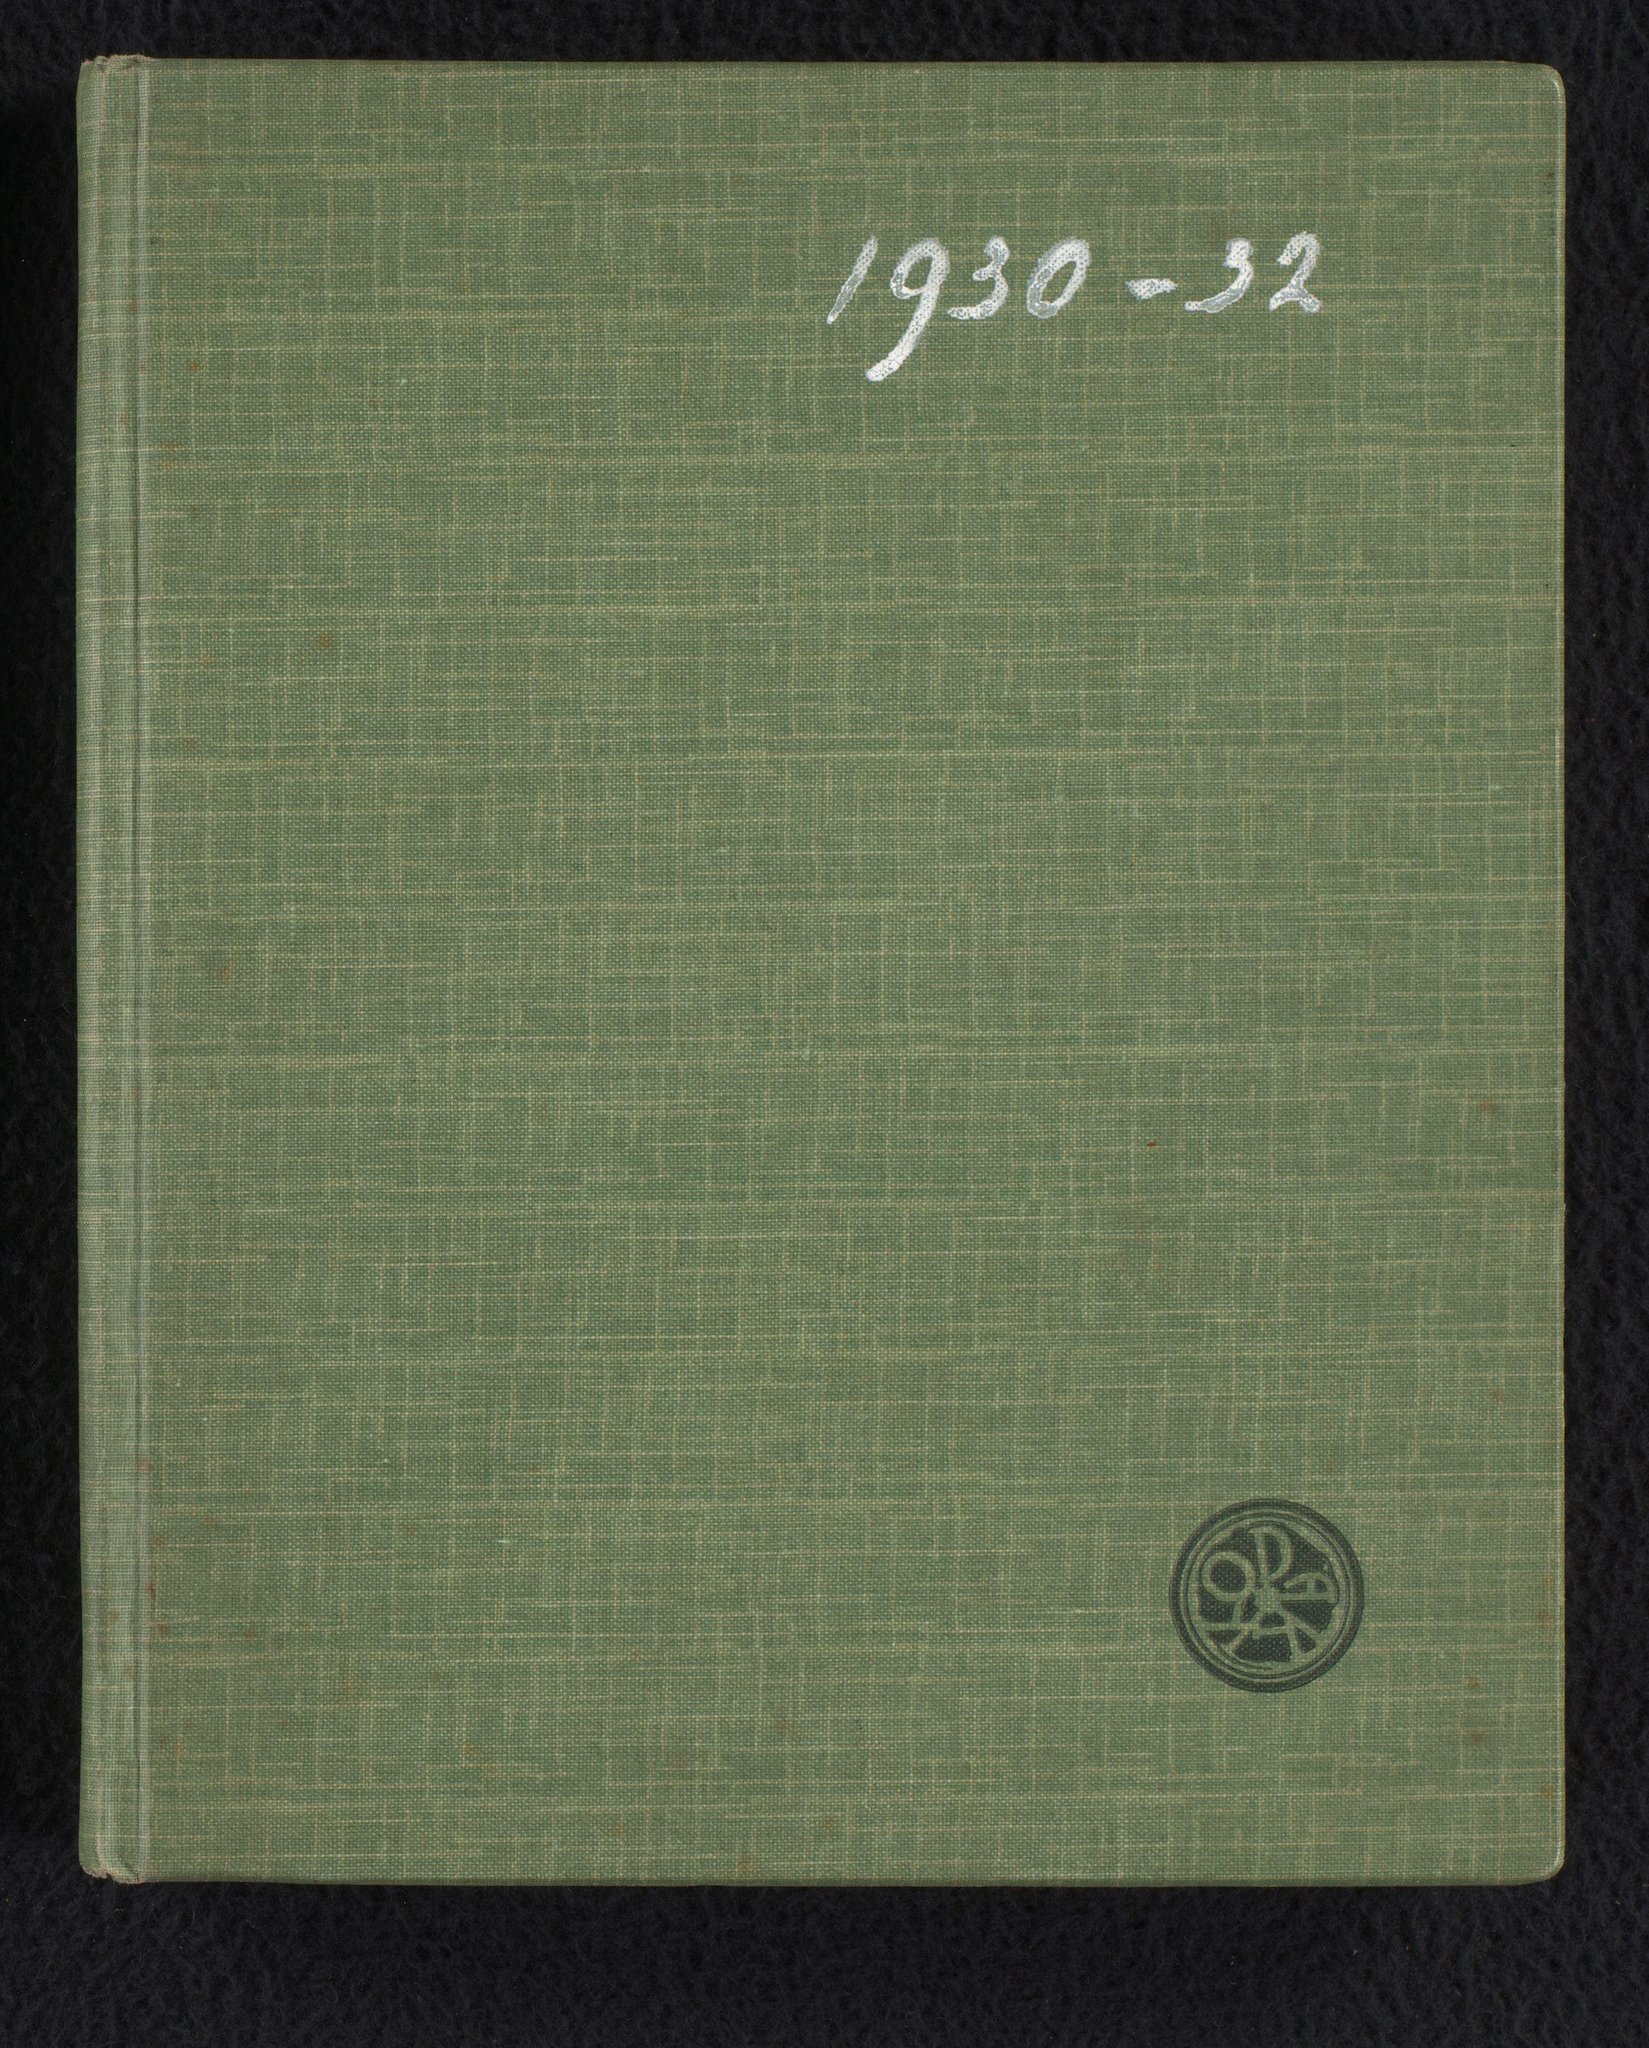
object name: photograph album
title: Fotoalbum van familie Van den Berg, 1930-1932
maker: frank willem van den berg (1912-1998)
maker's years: 1912-1998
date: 1930-1932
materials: paper, cardboard, ink, linen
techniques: gelatin silver print, pen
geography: netherlands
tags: batavia, amsterdam, hendrik herman van den berg, caroline louise van den berg-van den berg, frank willem van den berg (1912-1998), historical persons, village, race-track, mountains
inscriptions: inscription: ‘1930-1932’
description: Insteekalbum met 41 foto's op 24 bladen. Het album bevat foto's van een vakantie in Aken, de Alpen en een bezoek aan de renbanen van Hippodrome de Longchamp te Parijs. De fotograaf en samensteller van het album is waarschijnlijk Frank Willem van den Berg. De foto's waar hij zelf op staat zijn vermoedelijk door een familielid gemaakt.